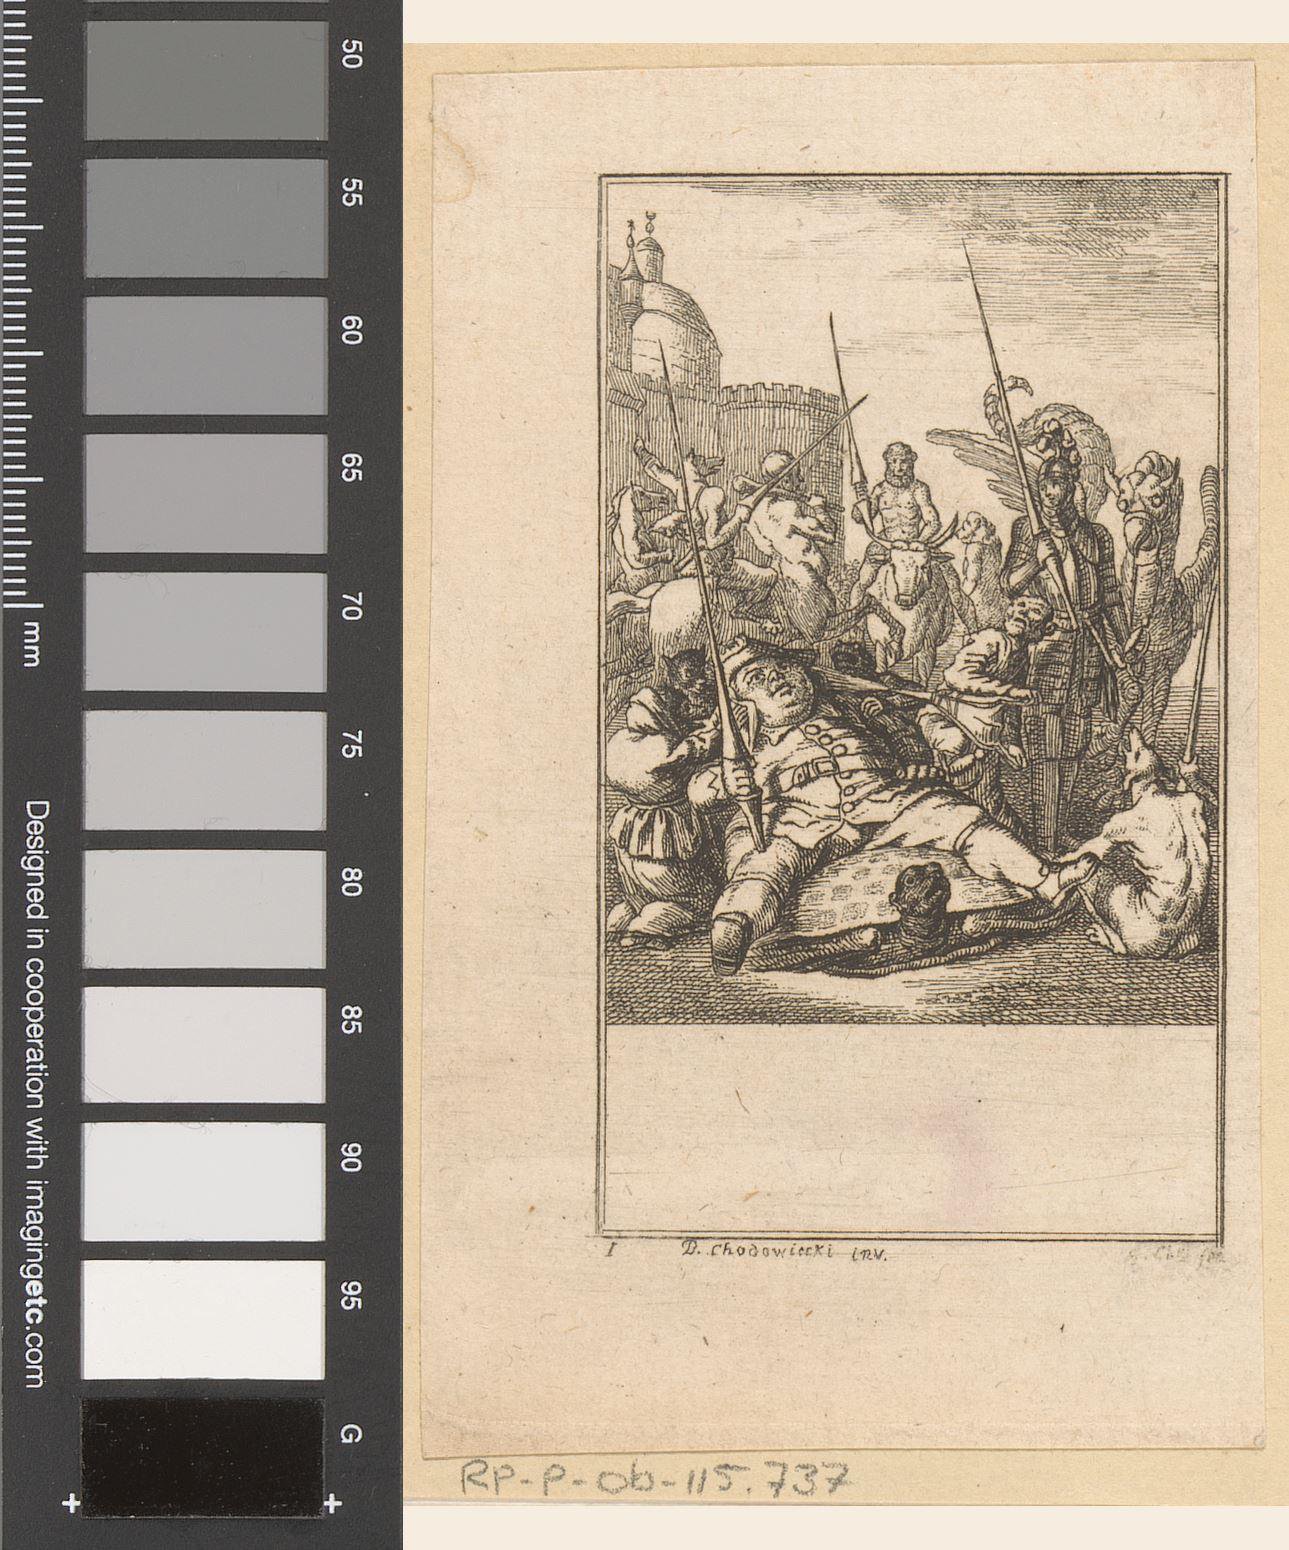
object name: print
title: Bont gezelschap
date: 1771-1772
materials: paper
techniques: etching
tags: fat (human type), fabulous animals ~ tortoises, monsters of mixed human and animal shape; 'mostri' (ripa), 'hippogriffe' (horse/eagle), (scenes from) specific works of literature: ariosto, orlando furioso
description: Vervaardigd voor Orlando Furioso van Ludovico Ariosto. Prent gebruikt voor: Almanac Genealogique pour l'année 1772. Berlijn: s.n.s.a.